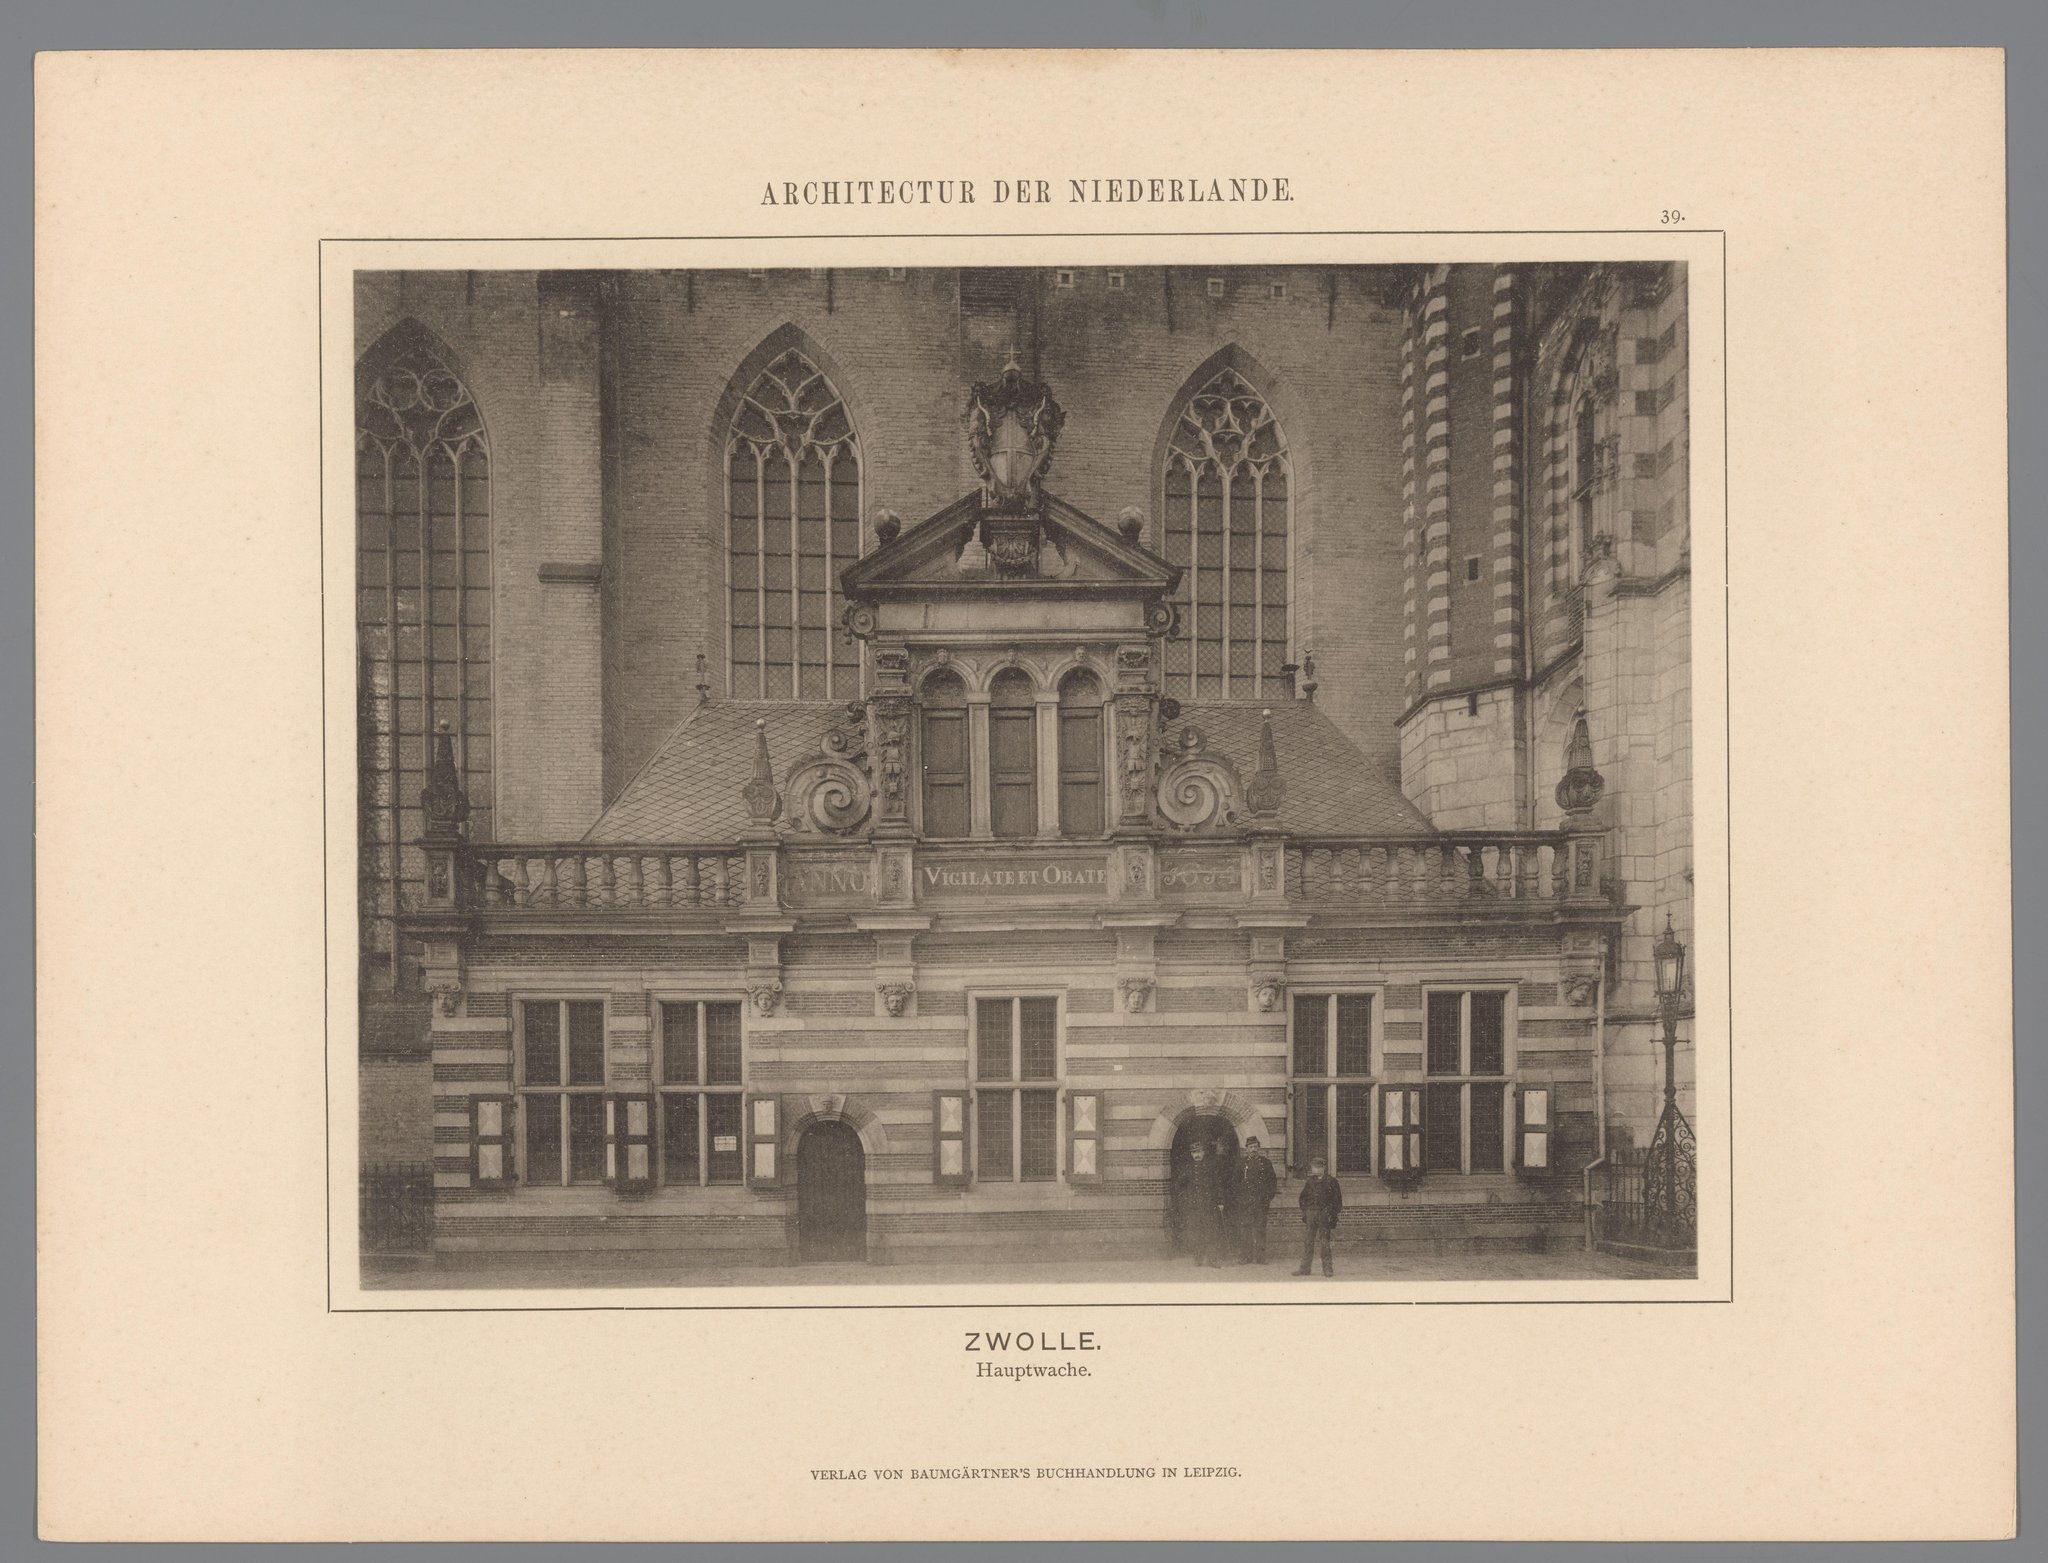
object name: photomechanical print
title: Zwolle, Hauptwache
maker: Anonymous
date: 1894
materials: paper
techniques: photograph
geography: leipzig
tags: decorated gable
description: Afdruk uit: Krook, L. Architectur der Niederlande. Leipzig: Baumgärtner's Buchhandlung, 1894.